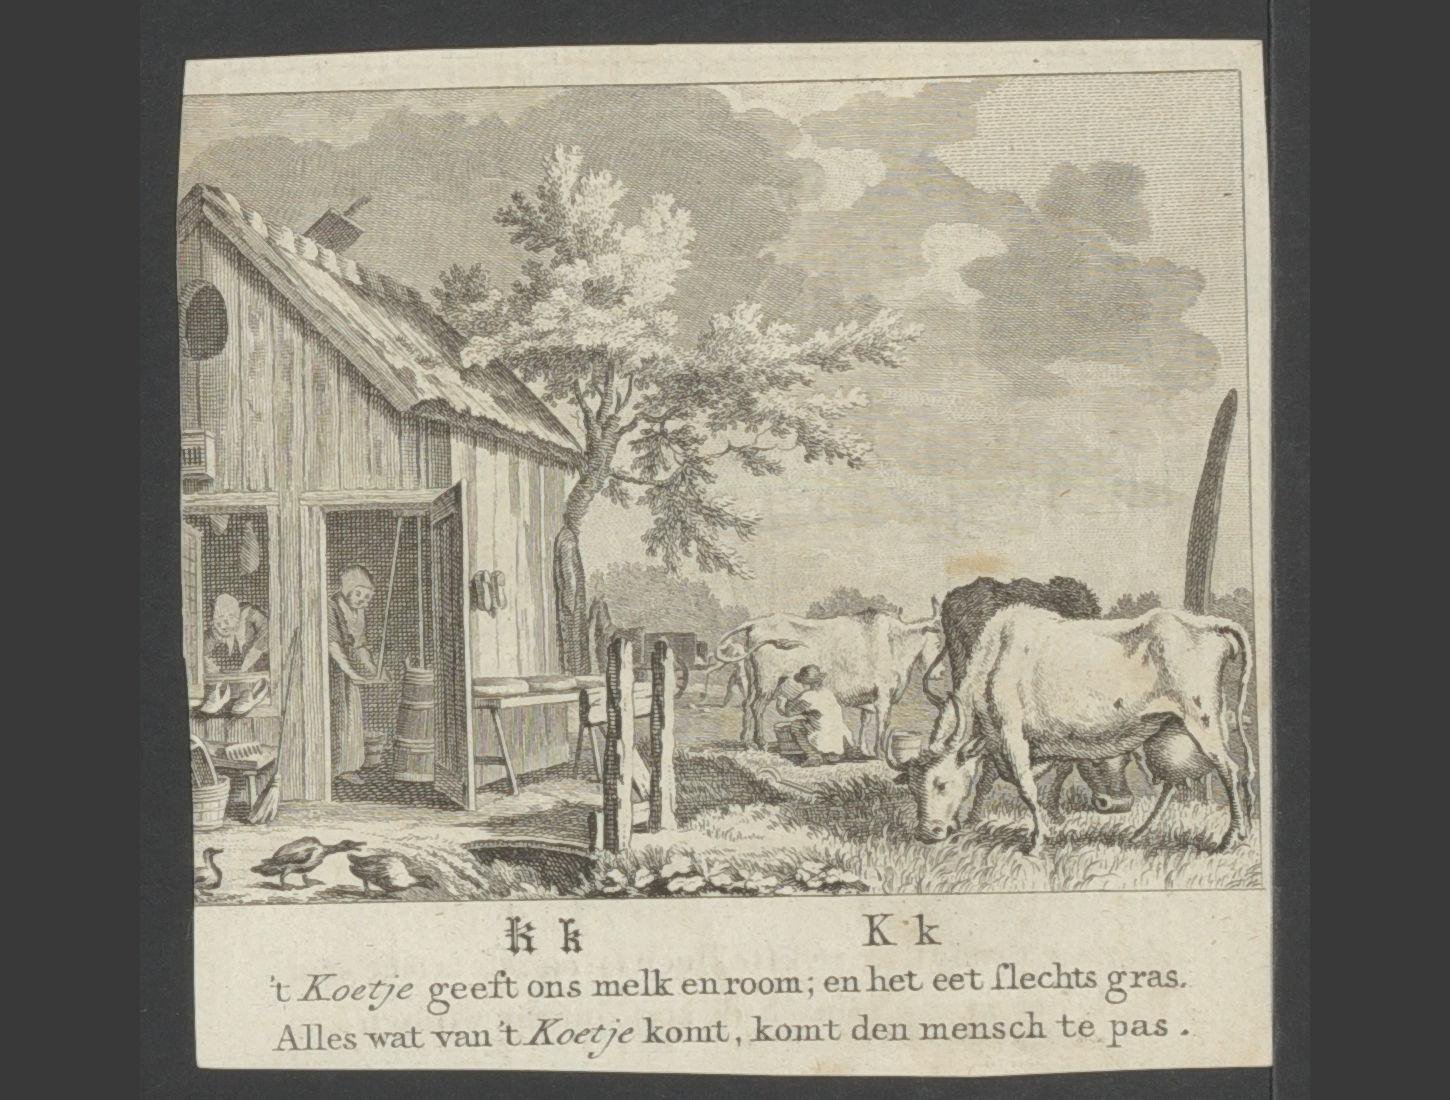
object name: print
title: Grazende koeien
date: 1781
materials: paper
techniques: engraving, etching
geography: amsterdam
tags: cow, letters, alphabet, script, milk, milking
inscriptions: stamp, collector's mark: Lugt 1641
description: Koeien grazen in de wei. Links een boerderij. Onder de voorstelling de letter K in twee verschillende lettertypes. Onderaan een tweeregelig vers over koeien en zuivel. Onderwerpsrubrieken binnen de Atlas Zeden en Gewoonten: Onderwijs en Wetenschappen, Opvoeding en Onderwijs, Haneboeken en schoolprenten.